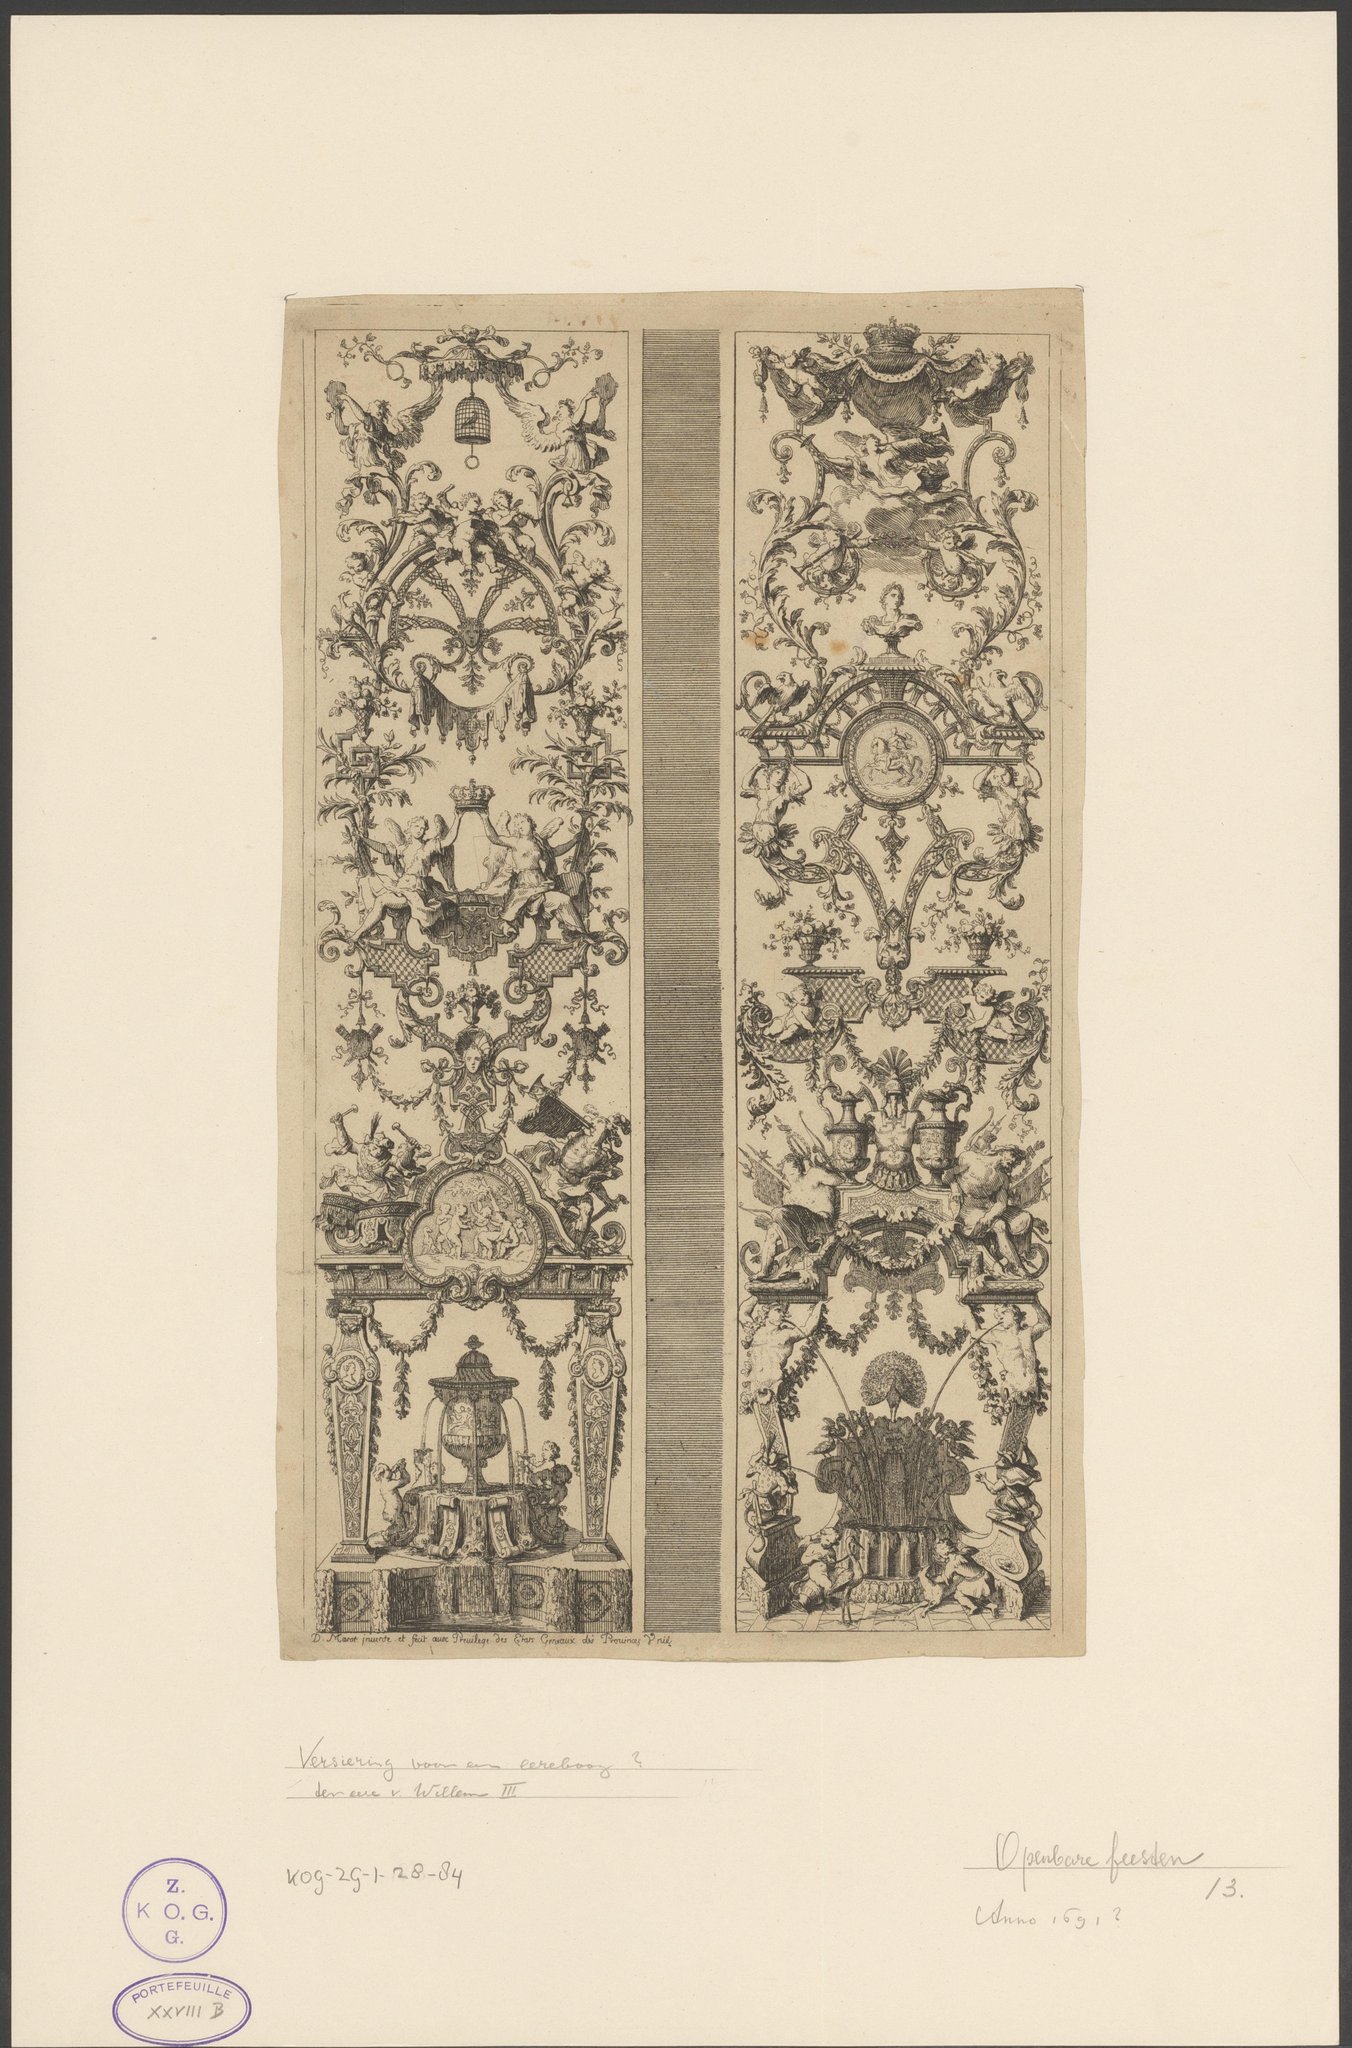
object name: print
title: Panelen met arabesken en moderne grotesken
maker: daniël marot (i)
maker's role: draughtsman, print maker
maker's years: 1661-1752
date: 1712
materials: paper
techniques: etching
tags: ornament ~ grotesque, monkeys, apes, vase ~ ornament, 'victoria'; 'vittoria', 'vittoria navale', 'vittoria degl'antichi' (ripa)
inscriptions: stamp, collector's mark: Lugt 1641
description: De panelen zijn van elkaar gescheiden door een brede strook. Links houden twee figuren die Victoria uitbeelden een kroon omhoog, rechts staan twee aapjes onder een wapentrofee. Uit een serie van zes bladen, waarvan vier bladen met de vier elementen en twee bladen waarop telkens twee verticale panelen staan. Onderwerpsrubrieken binnen de Atlas Zeden en Gewoonten: Zeden en Gewoonten in Engeren Zin. Volksleven. Openbare feesten. Vorstelijke intochten, (Illuminaties, vuurwerken en dergelijke, openbare feesten).